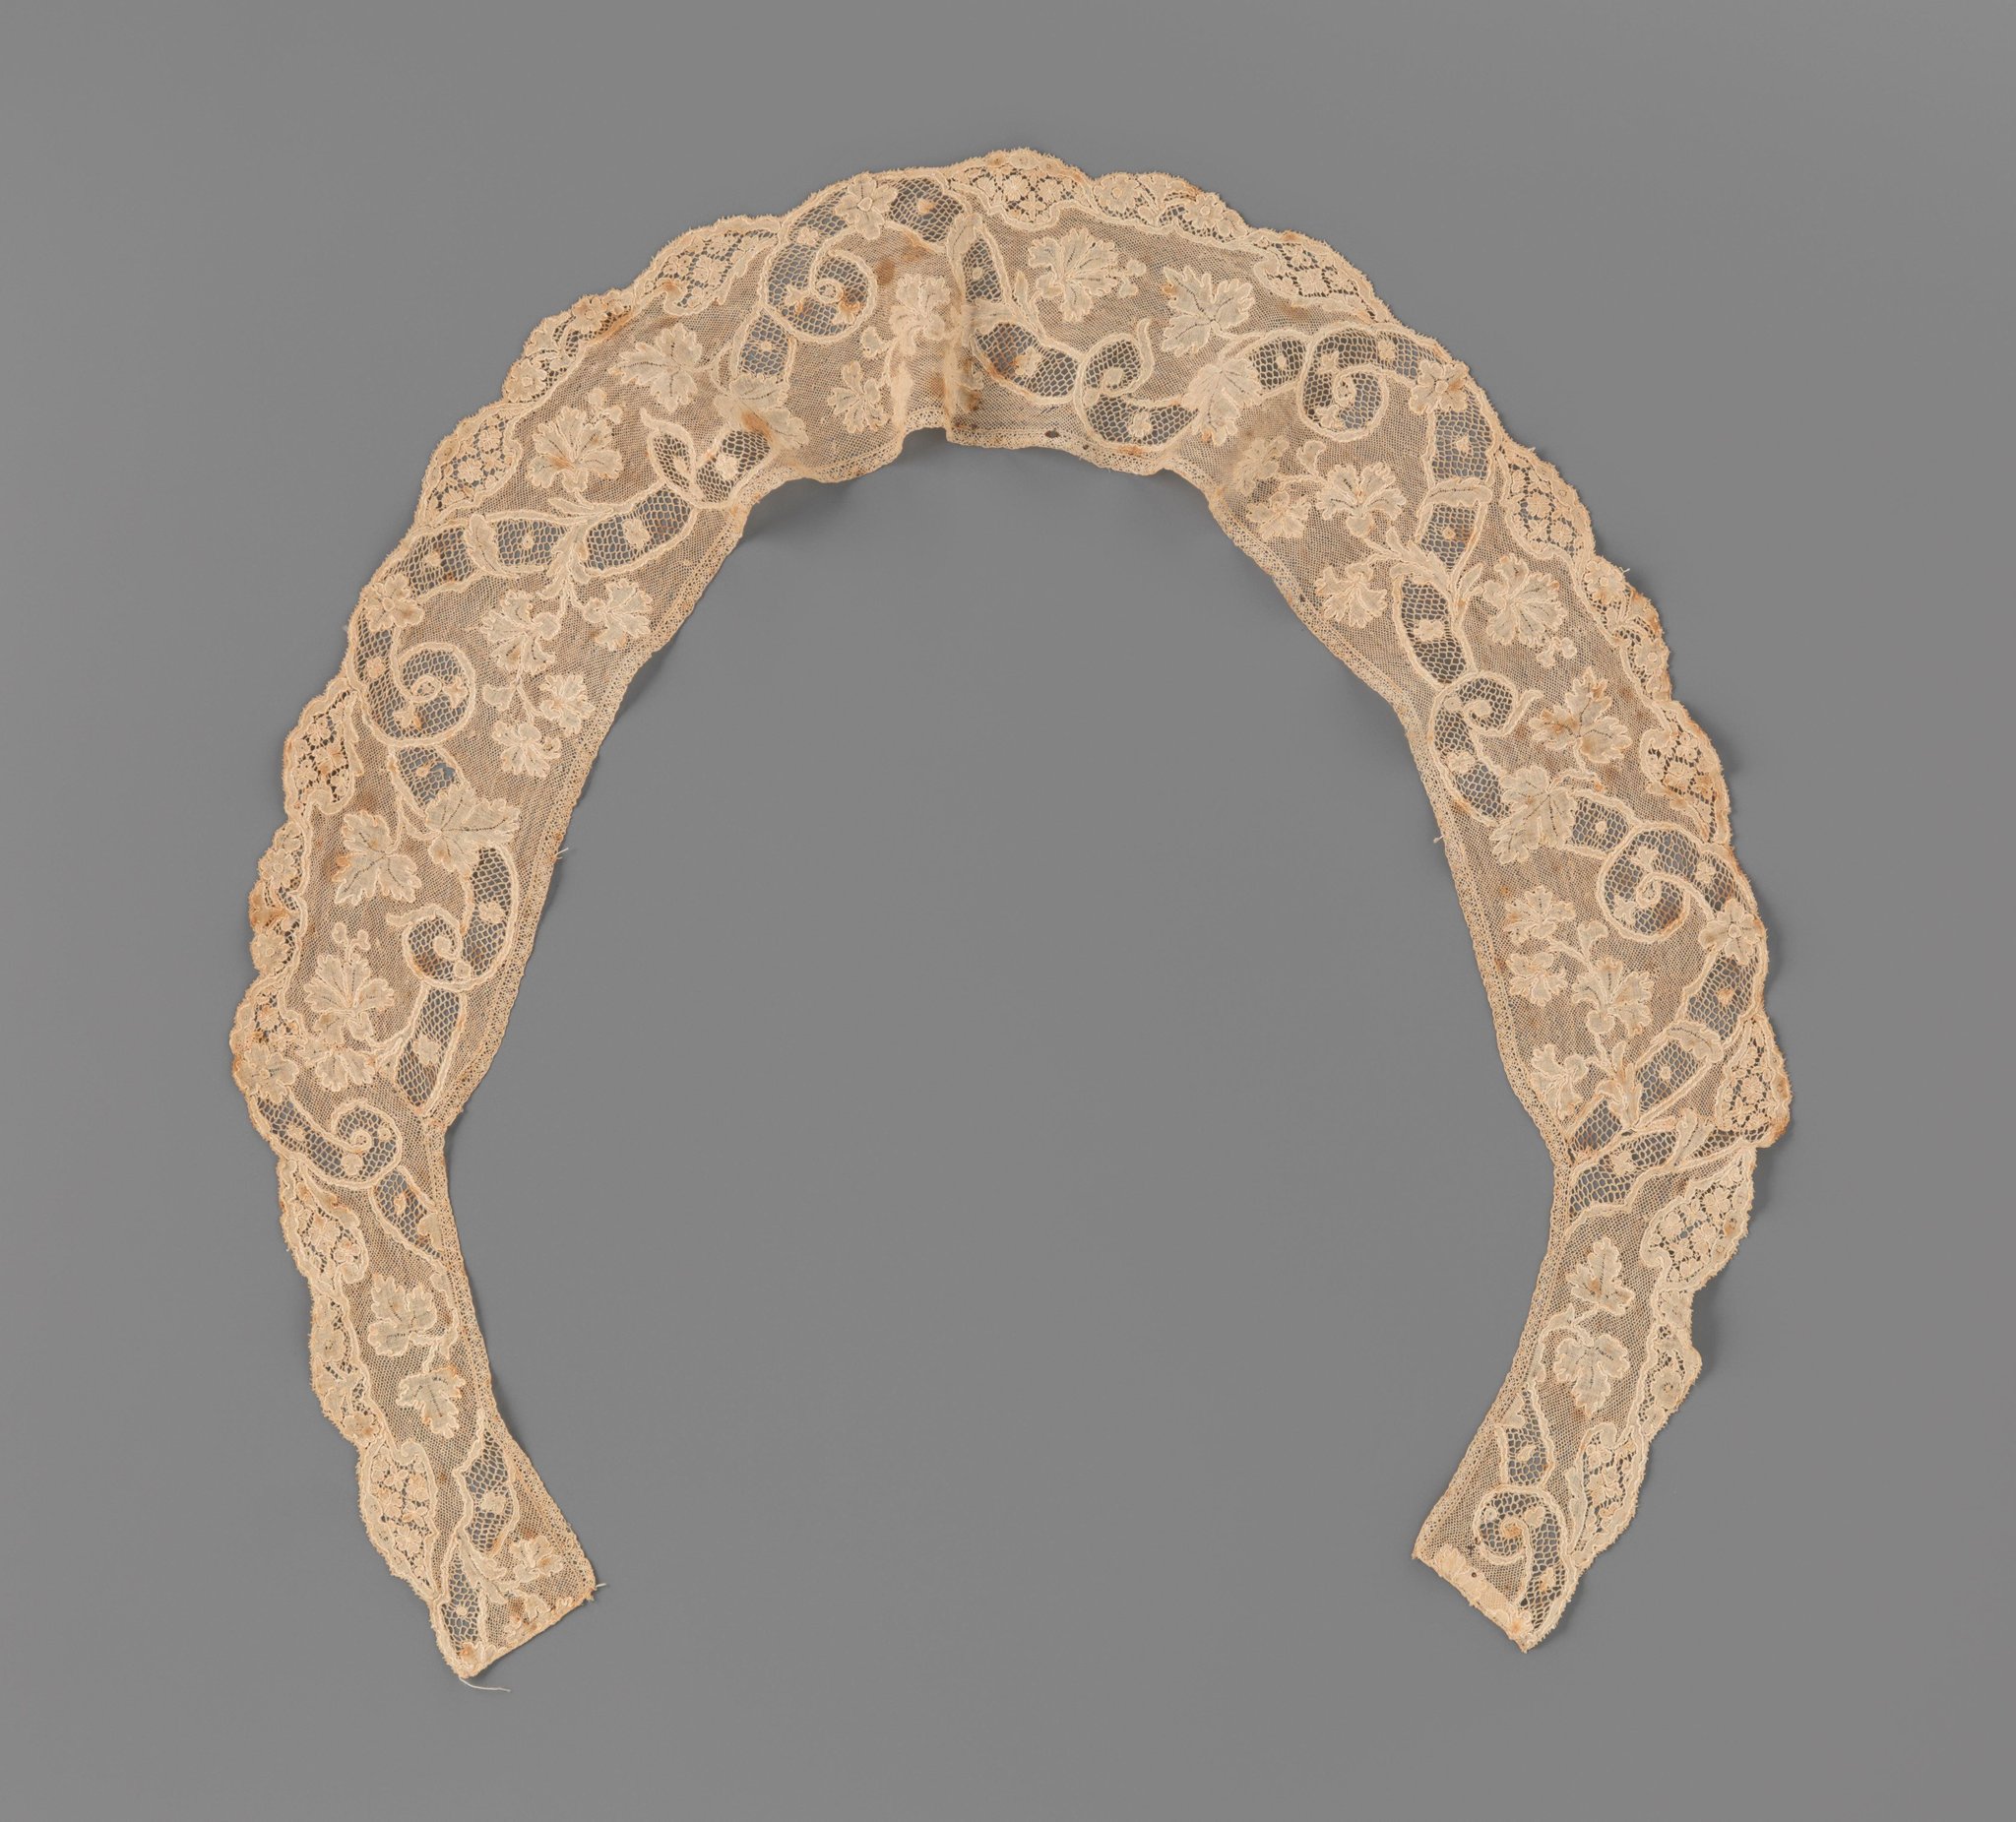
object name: collar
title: Kraag van Mechelse kant, rond model met gepicoteerde schulpen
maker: Anonymous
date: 1750-1800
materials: linen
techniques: lace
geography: mechelen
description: Kraag van Mechelse kant, rond model met gepicoteerde schulpen. Het patroon heeft een riviere van vierkante mazen gedekt en omringd door lofwerk met anjers en een geschulpte opengewerkte rand met bloemen.